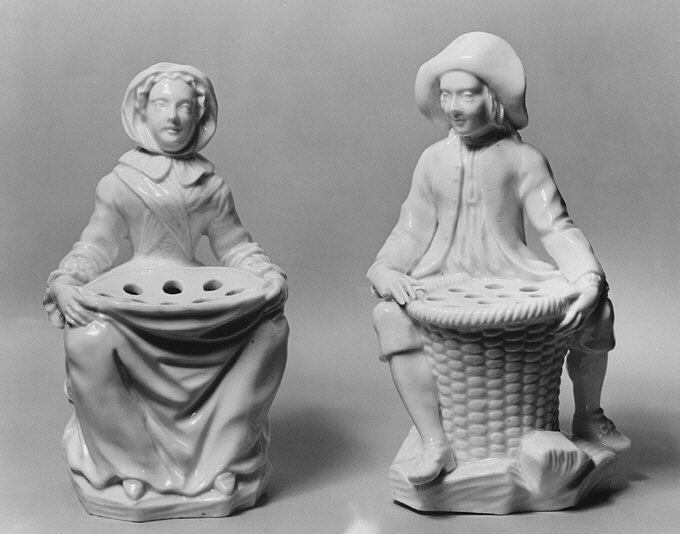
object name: figure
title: Pair of flower sellers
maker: saint-cloud factory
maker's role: factory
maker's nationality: french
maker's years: 1693-1766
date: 1740-1750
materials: soft paste porcelain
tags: men,women